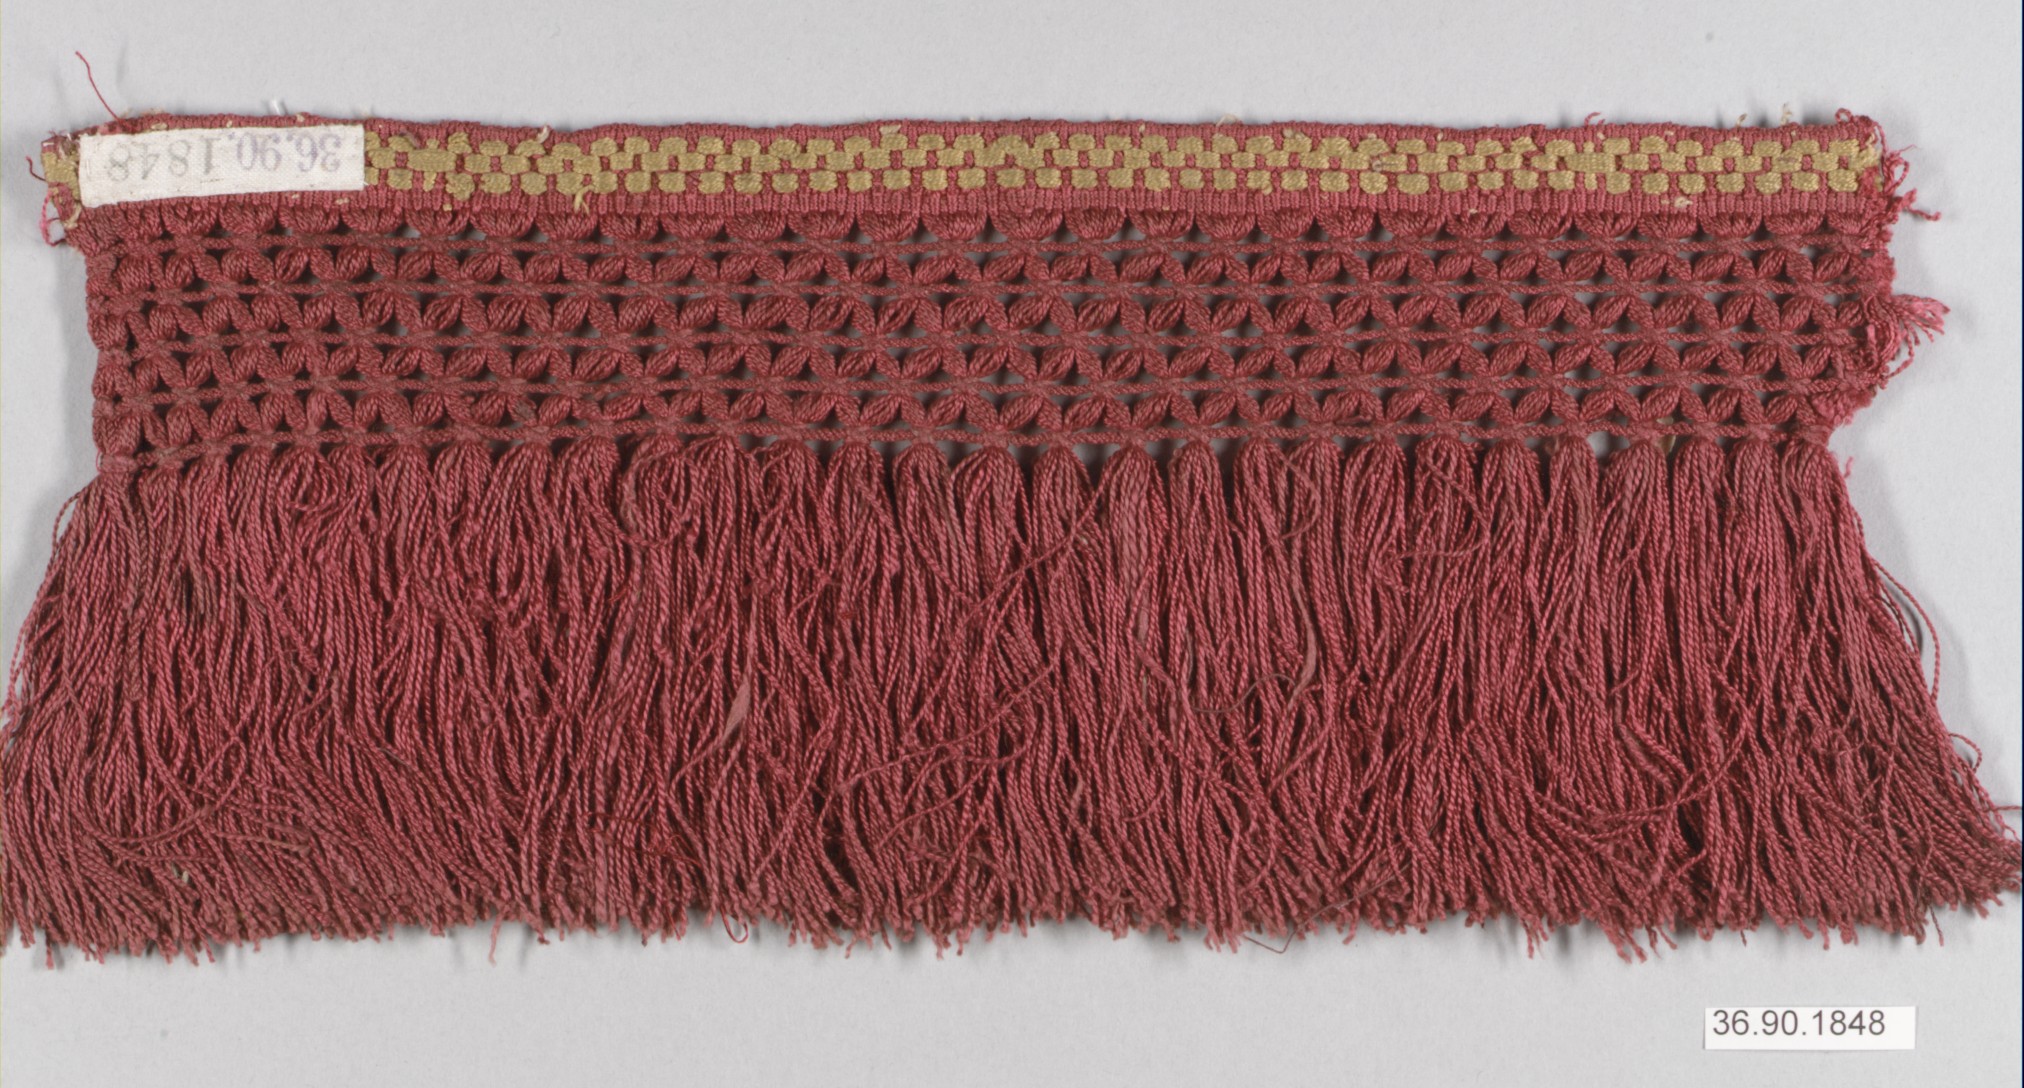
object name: fringe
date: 1801-1833